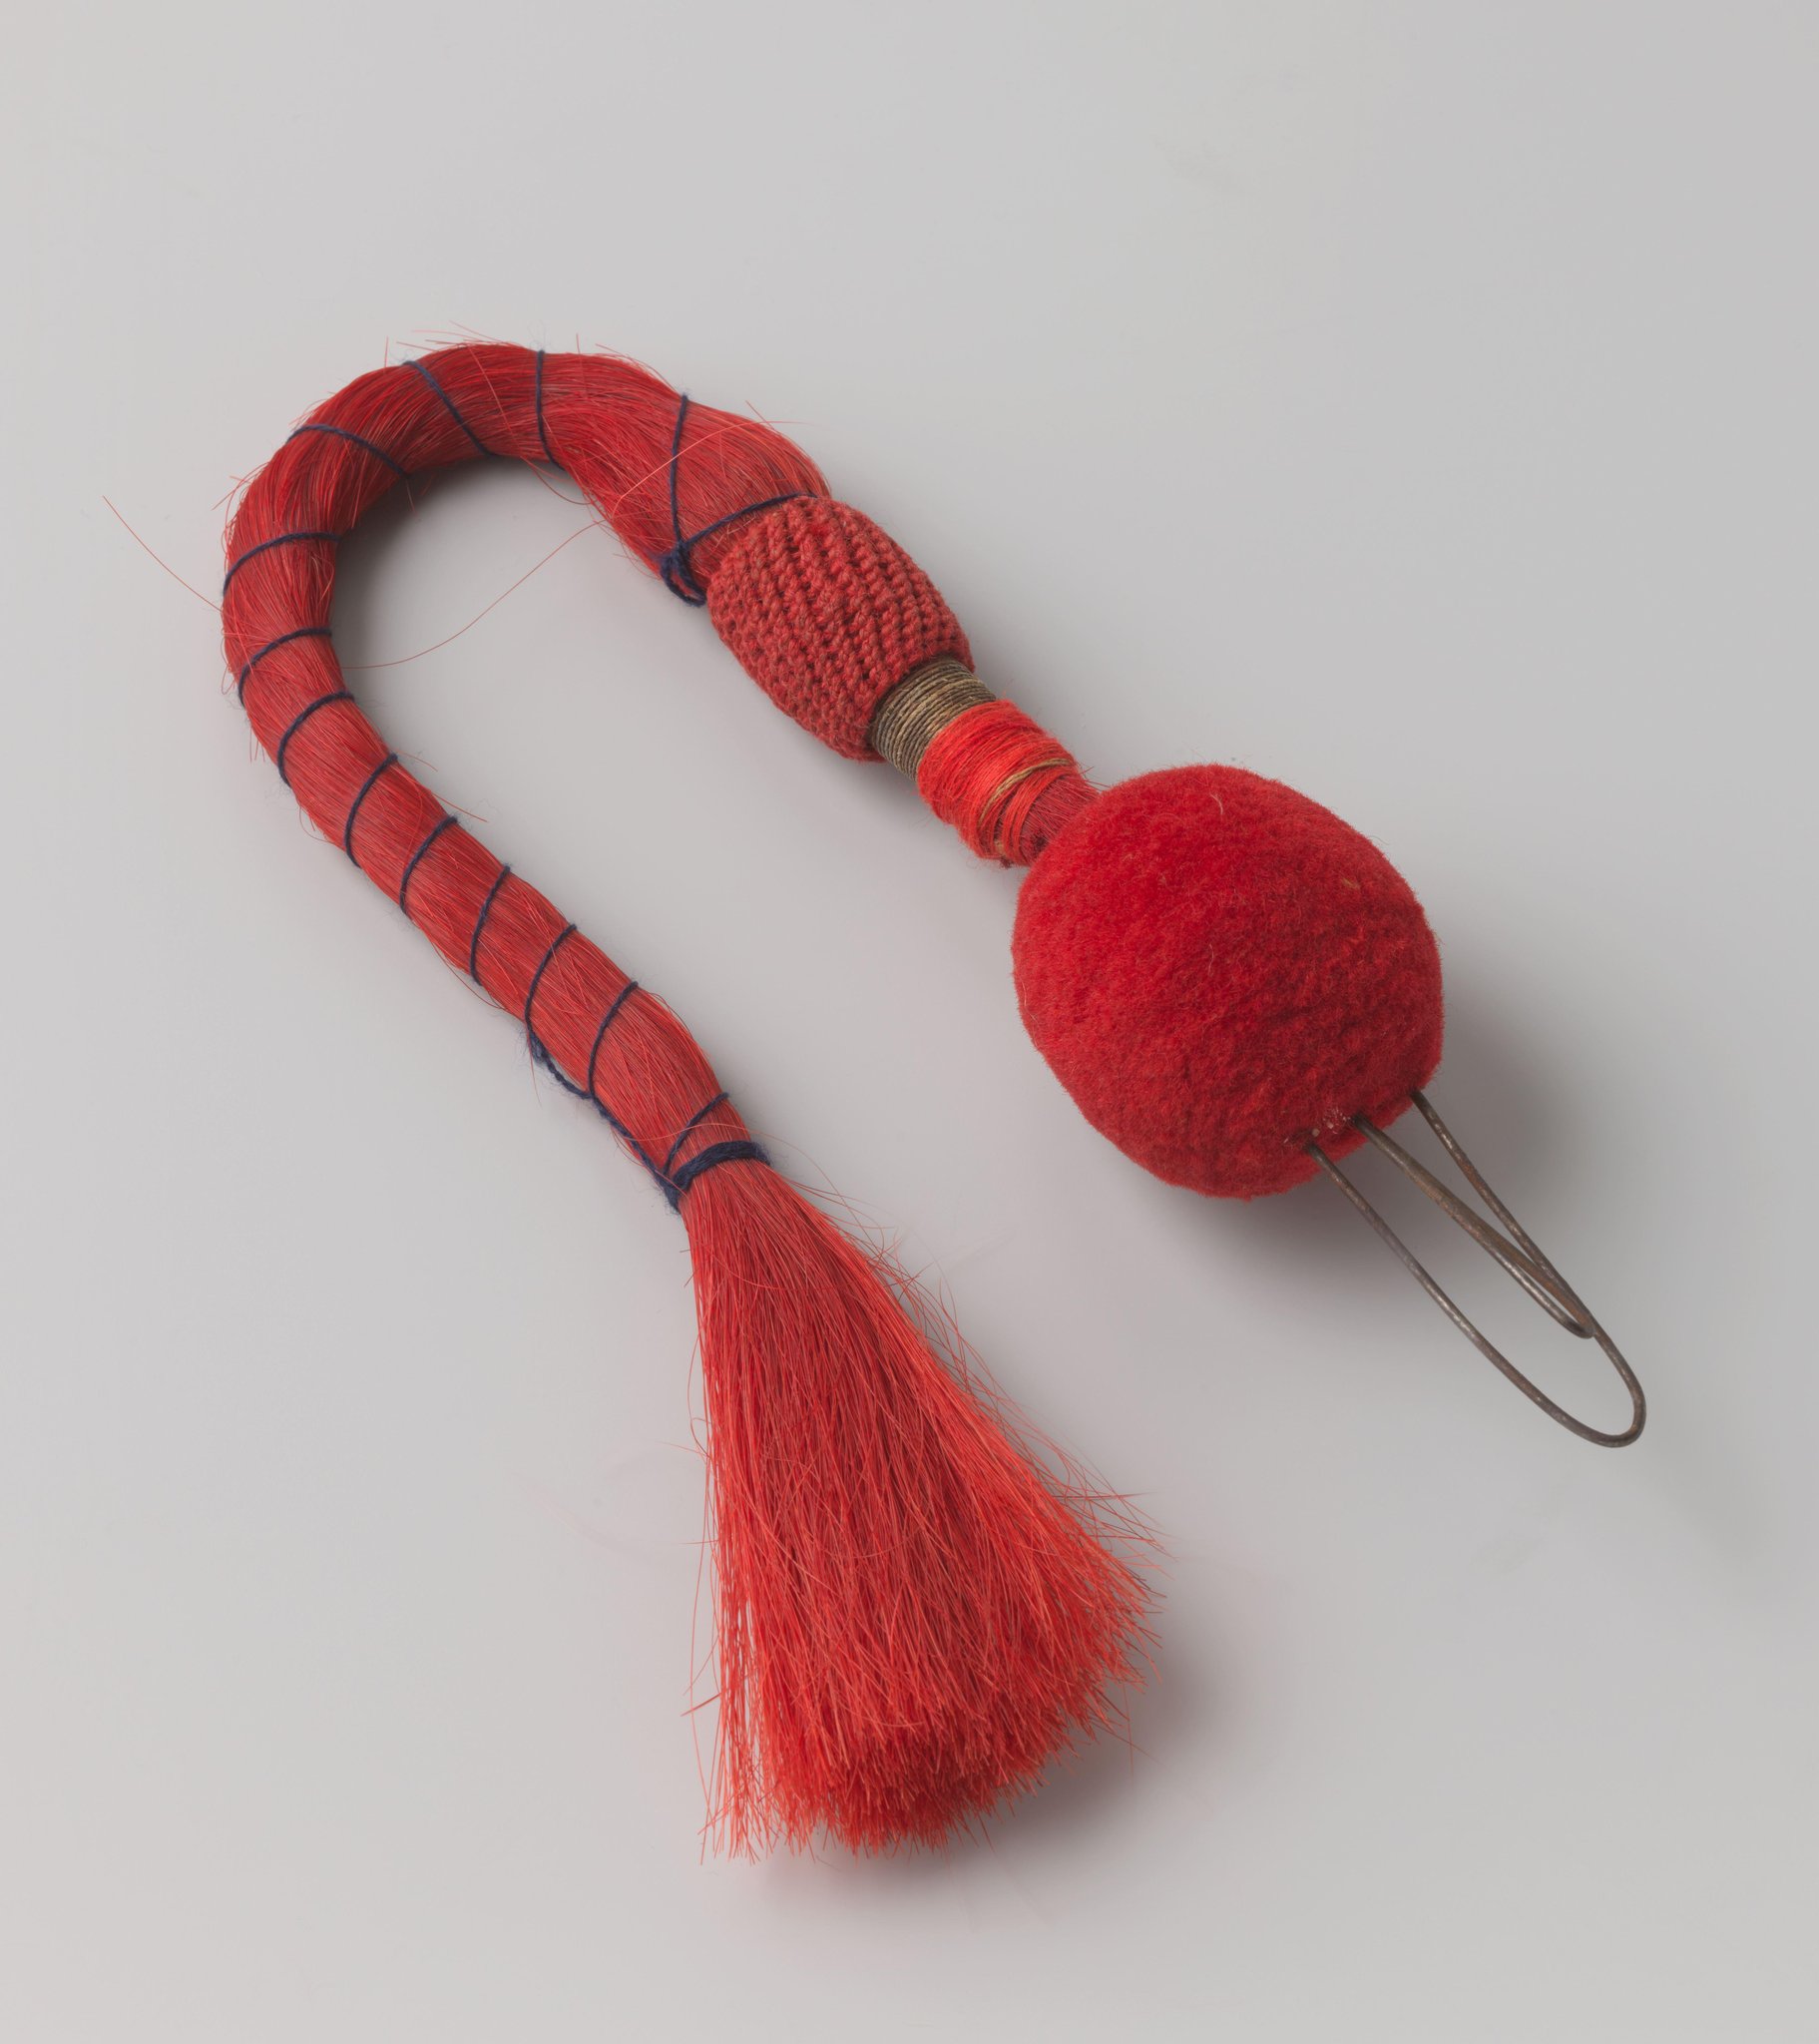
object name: plume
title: Bal met pluim van vrijwillige schutter te paard van Amsterdam ca.1831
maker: Anonymous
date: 1831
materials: hair, metal, fiber, wool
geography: netherlands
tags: amsterdam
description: Bal van rode wol met houten kern, gezet op wit metalen draad. Door de kern loopt een wit metalen draad, waarop een rode paardenharen staart is gemonteerd, vastgezet met rood touw en wol rond aan het staart, rood wollen geknoopte koker. De pluim wordt met blauwe wol bijeengehouden.